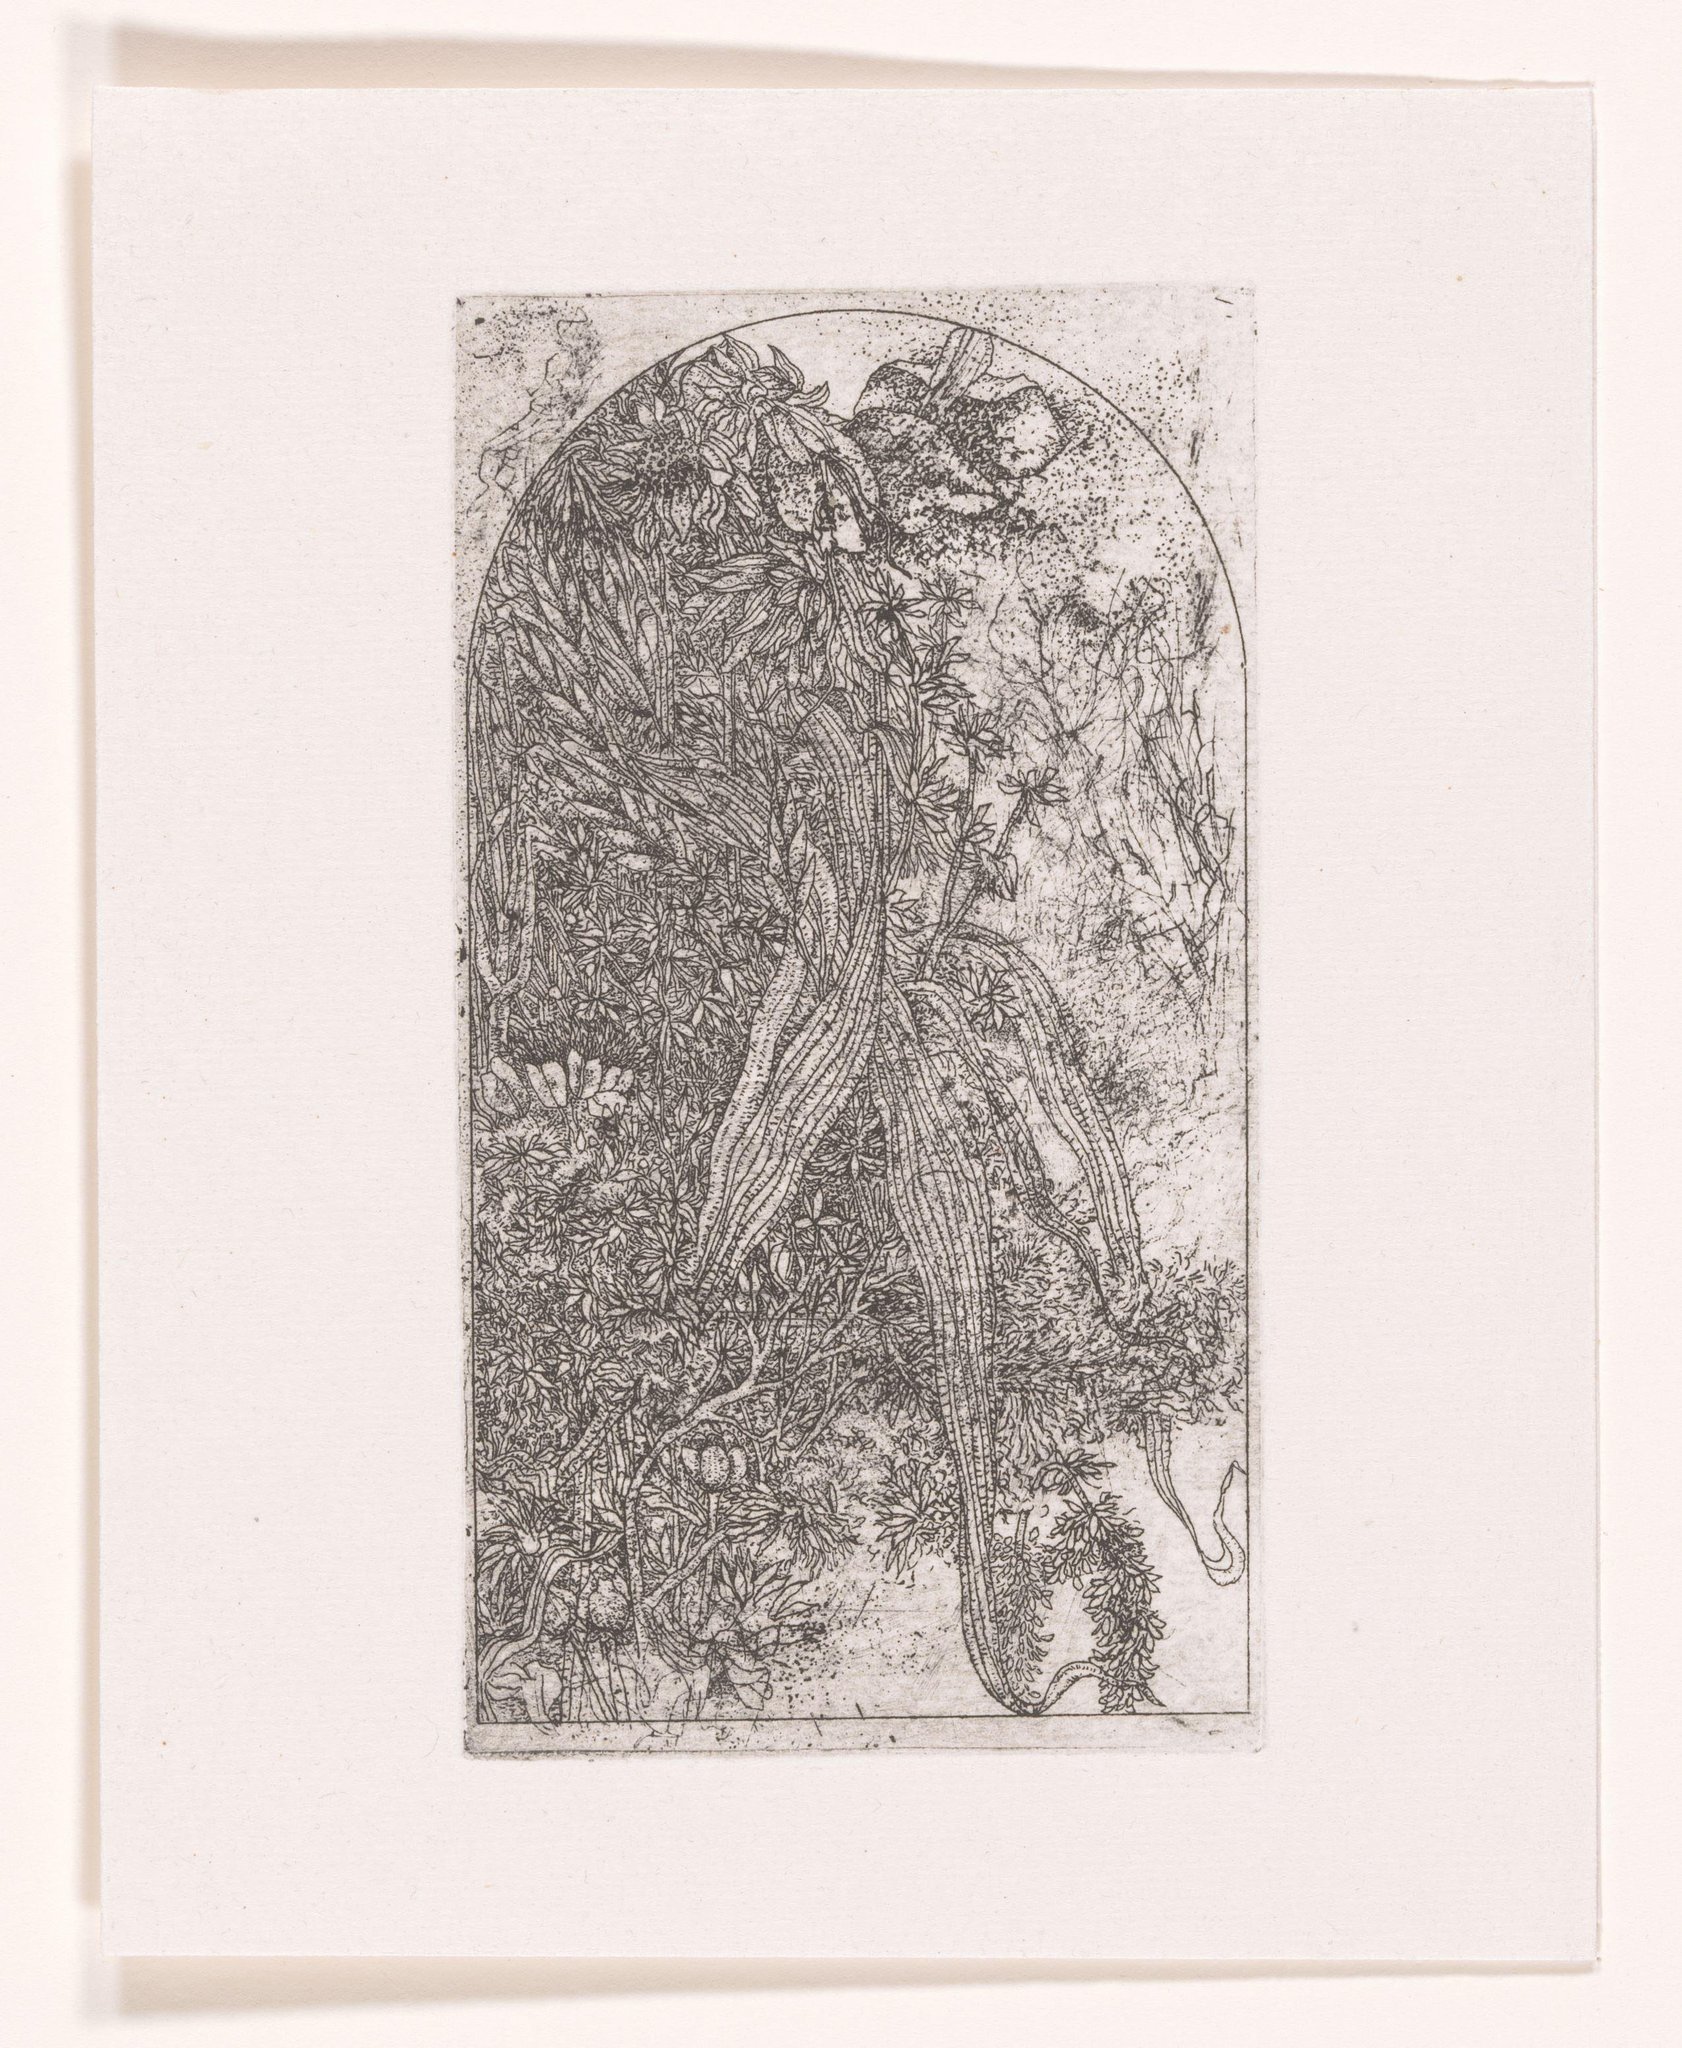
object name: print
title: Bloemen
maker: kees stoop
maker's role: draughtsman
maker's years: 1929-2019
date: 1944-1990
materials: paper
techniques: etching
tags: flowers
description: Bloemen binnen rondboog, met lange neerhangende bladeren